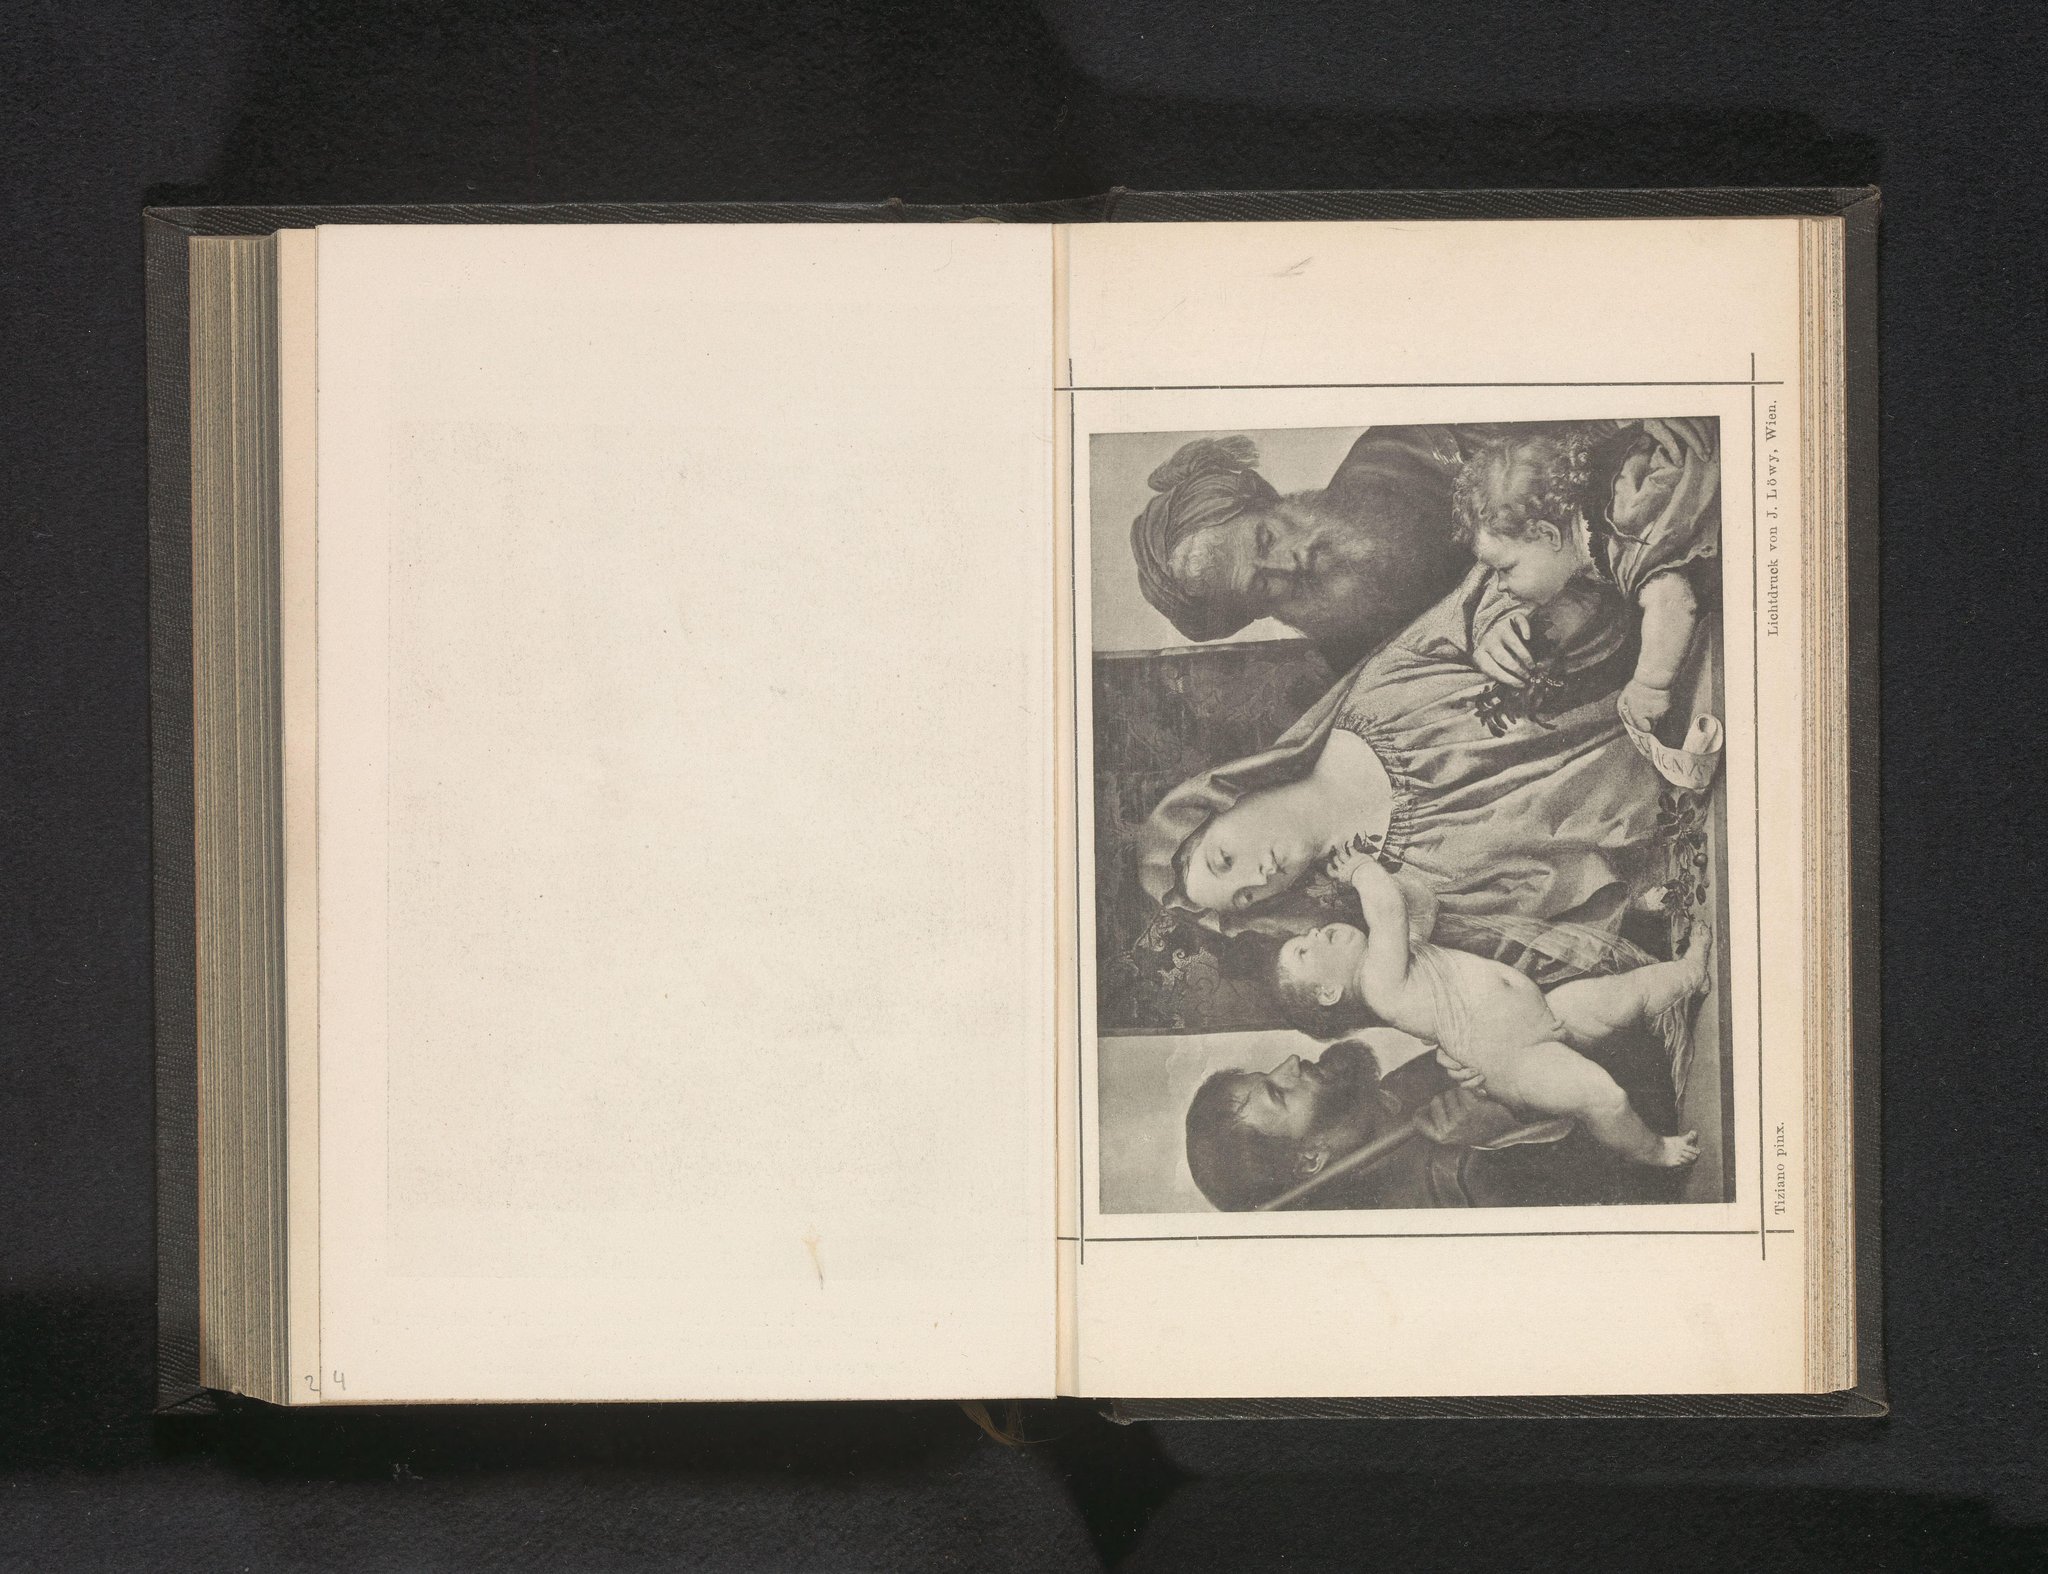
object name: photomechanical print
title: Reproductie van Madonna delle Ciliegie door Titiaan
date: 1887-1892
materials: paper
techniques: autotype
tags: specific types of madonna with others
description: Prent op negende ongenummerde pagina na pagina 520.